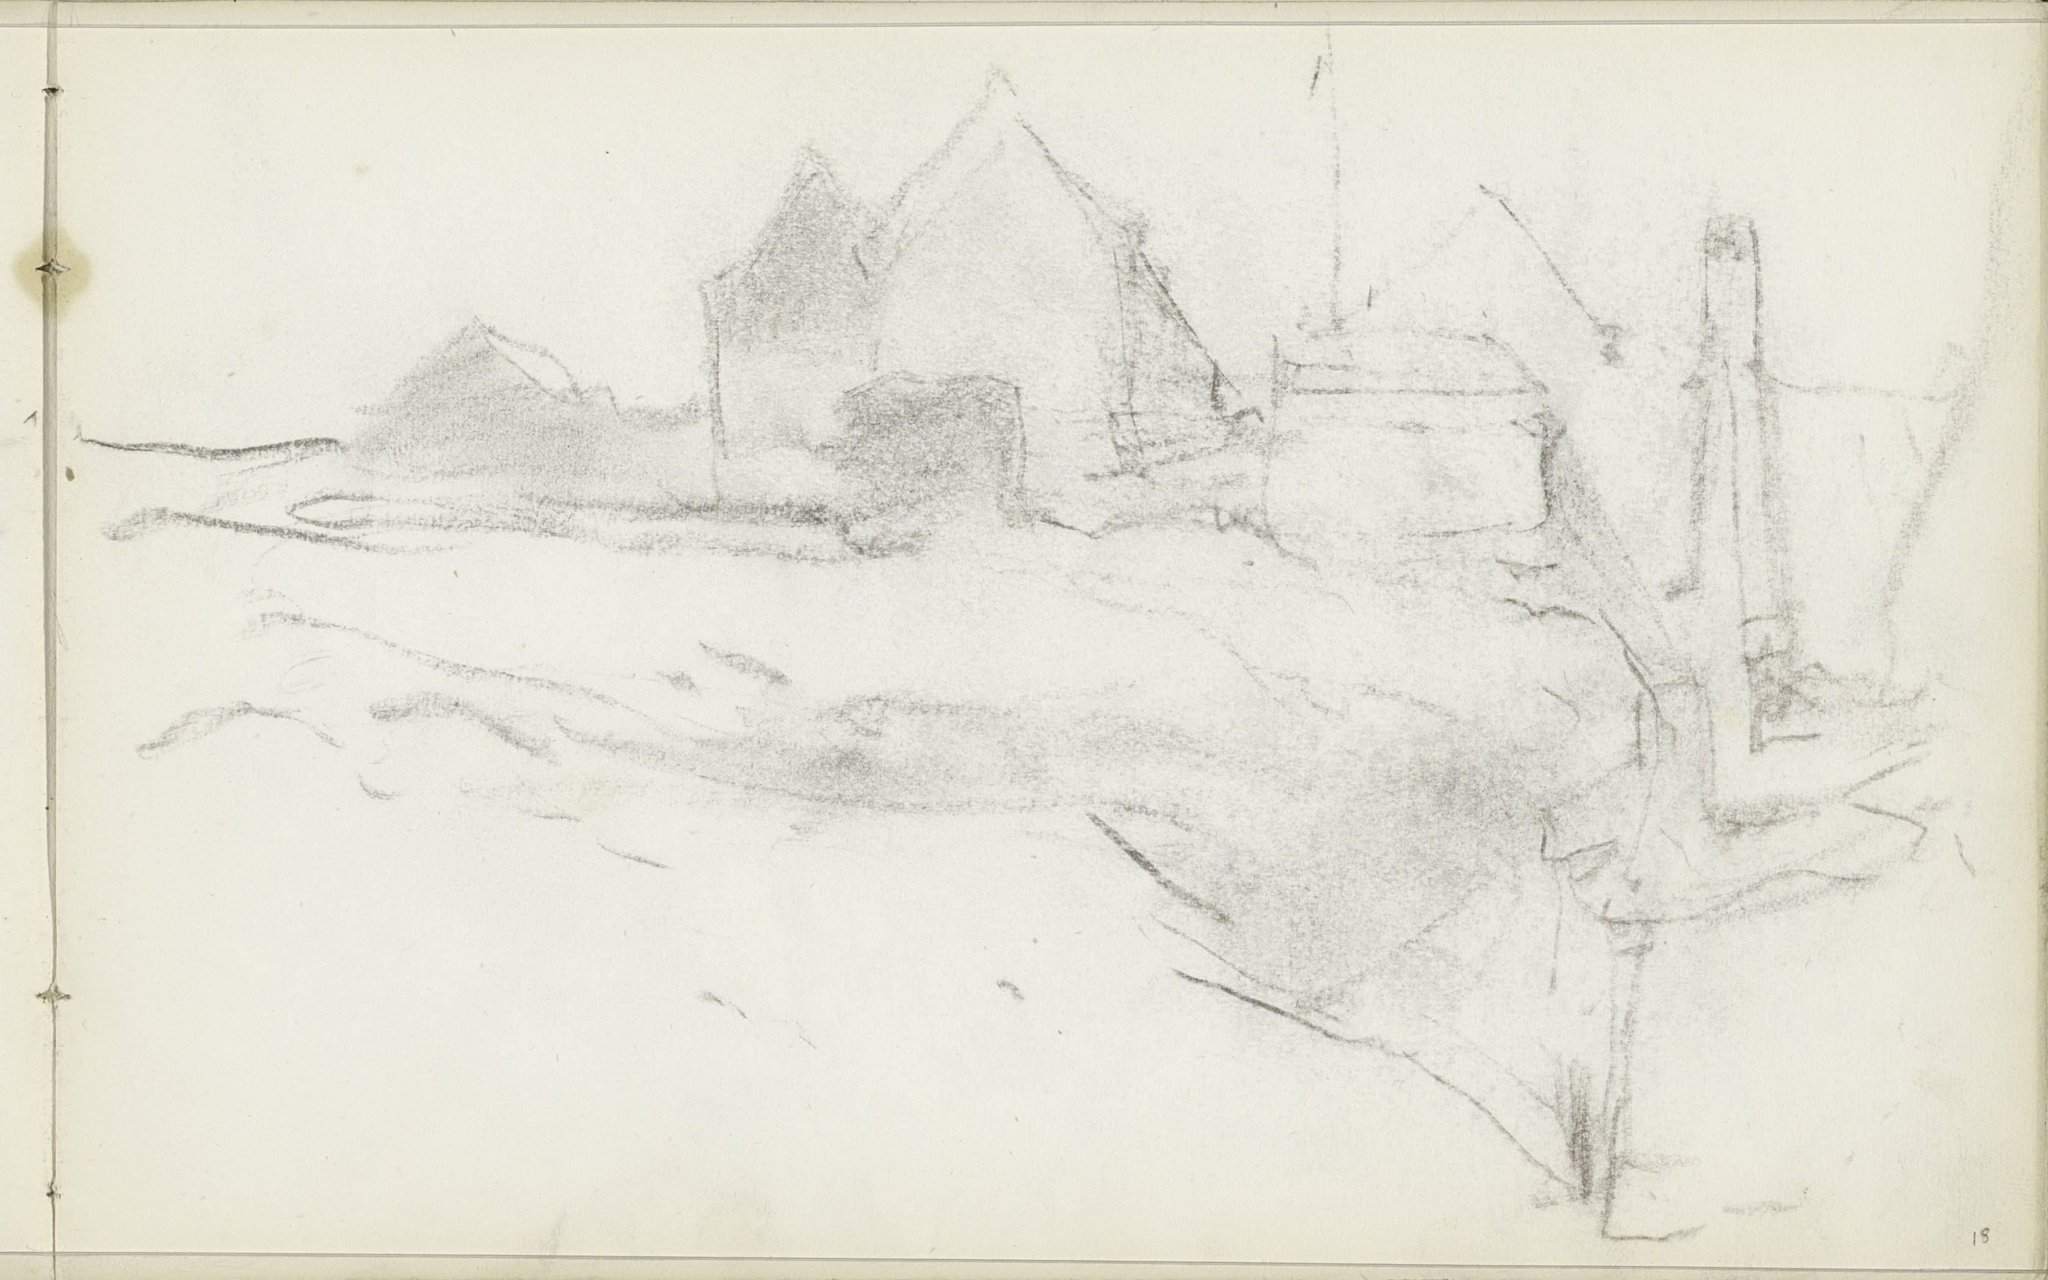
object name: sketchbook leaf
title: Huizen op het duin bij Scheveningen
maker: johannes bosboom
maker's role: draughtsman, painter, print maker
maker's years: 1817-1891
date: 1873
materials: chalk, paper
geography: scheveningen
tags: dunes (sea not visible); in the dunes, cottage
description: Blad 18 recto uit een schetsboek met 39 bladen.